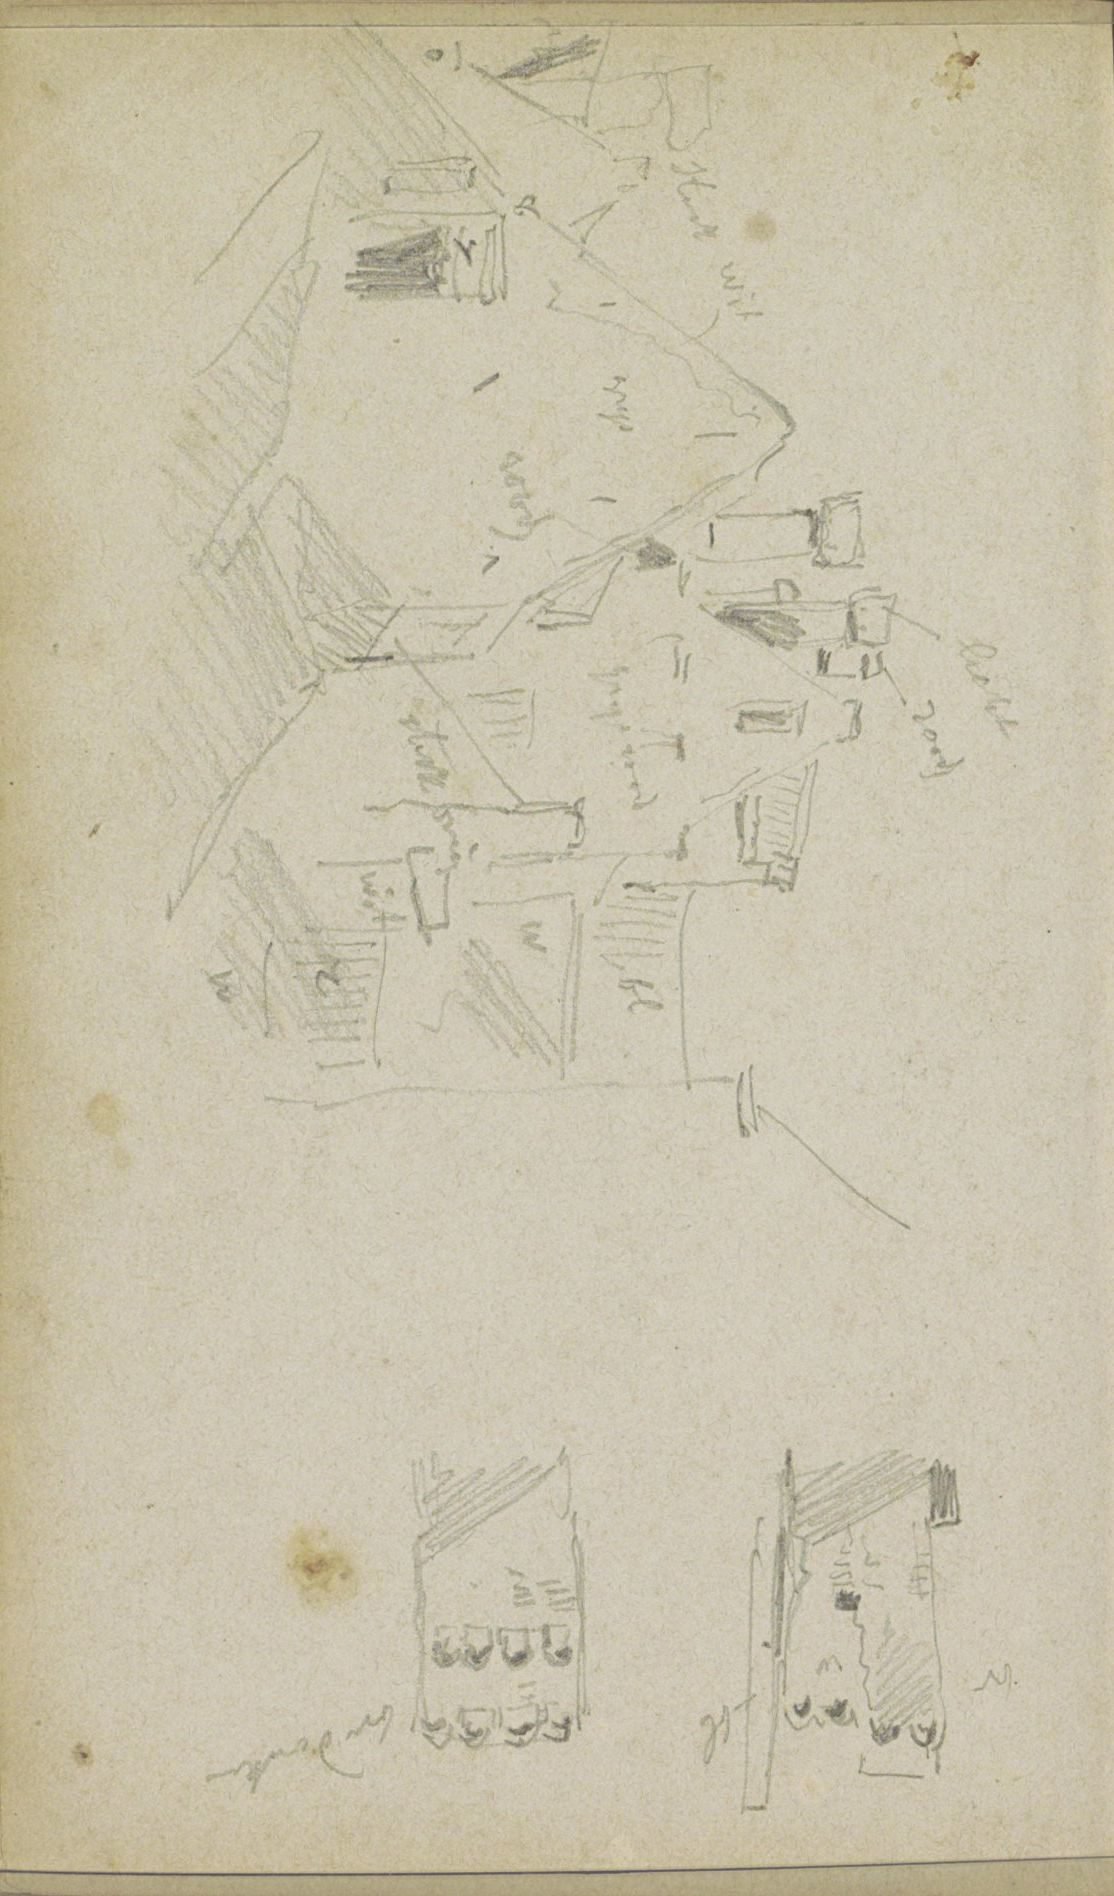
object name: sketchbook leaf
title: Gezicht op een groep gebouwen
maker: adrianus eversen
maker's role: draughtsman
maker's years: 1818-1897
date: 1828-1897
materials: paper, pencil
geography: netherlands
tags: chimney, urban housing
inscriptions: kleurnotitie, handgeschreven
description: Links een groep gebouwen in vogelvluchtperspectief. Rechts mogelijk twee schoorstenen. Blad 42 verso uit een schetsboek met 69 bladen vervaardigd in de omgeving van Delft, Rotterdam, Oudewater en Harlingen.